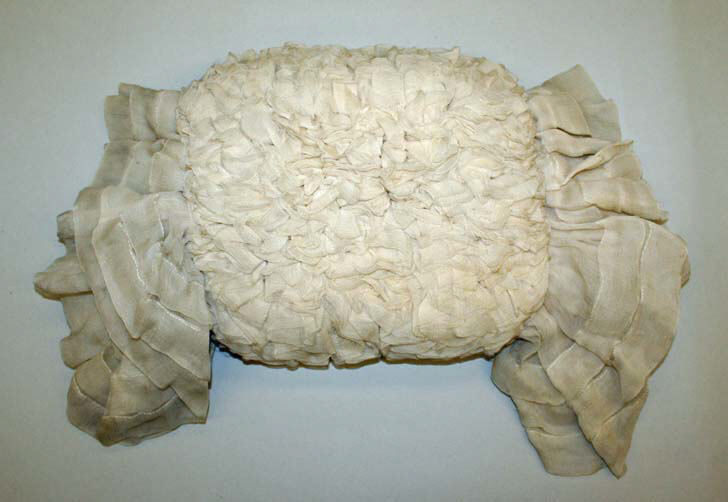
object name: muff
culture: american or european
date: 1900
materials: silk